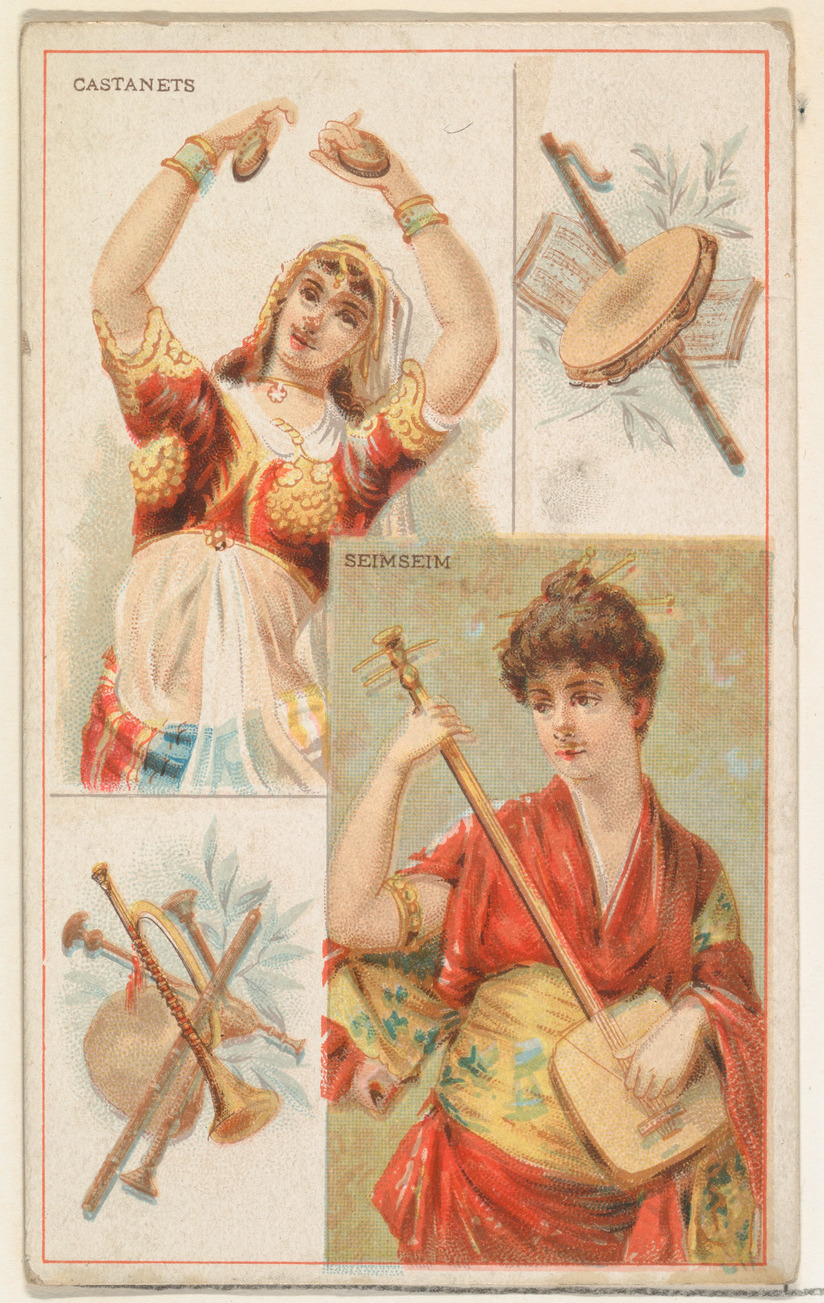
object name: print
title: Castanets and Seimseim, from the Musical Instruments series (N121) issued by Duke Sons & Co. to promote Honest Long Cut Tobacco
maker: w. duke, sons & co.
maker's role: publisher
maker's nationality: american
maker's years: 1870-1920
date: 1888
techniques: color lithograph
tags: musical instruments,women,dancing